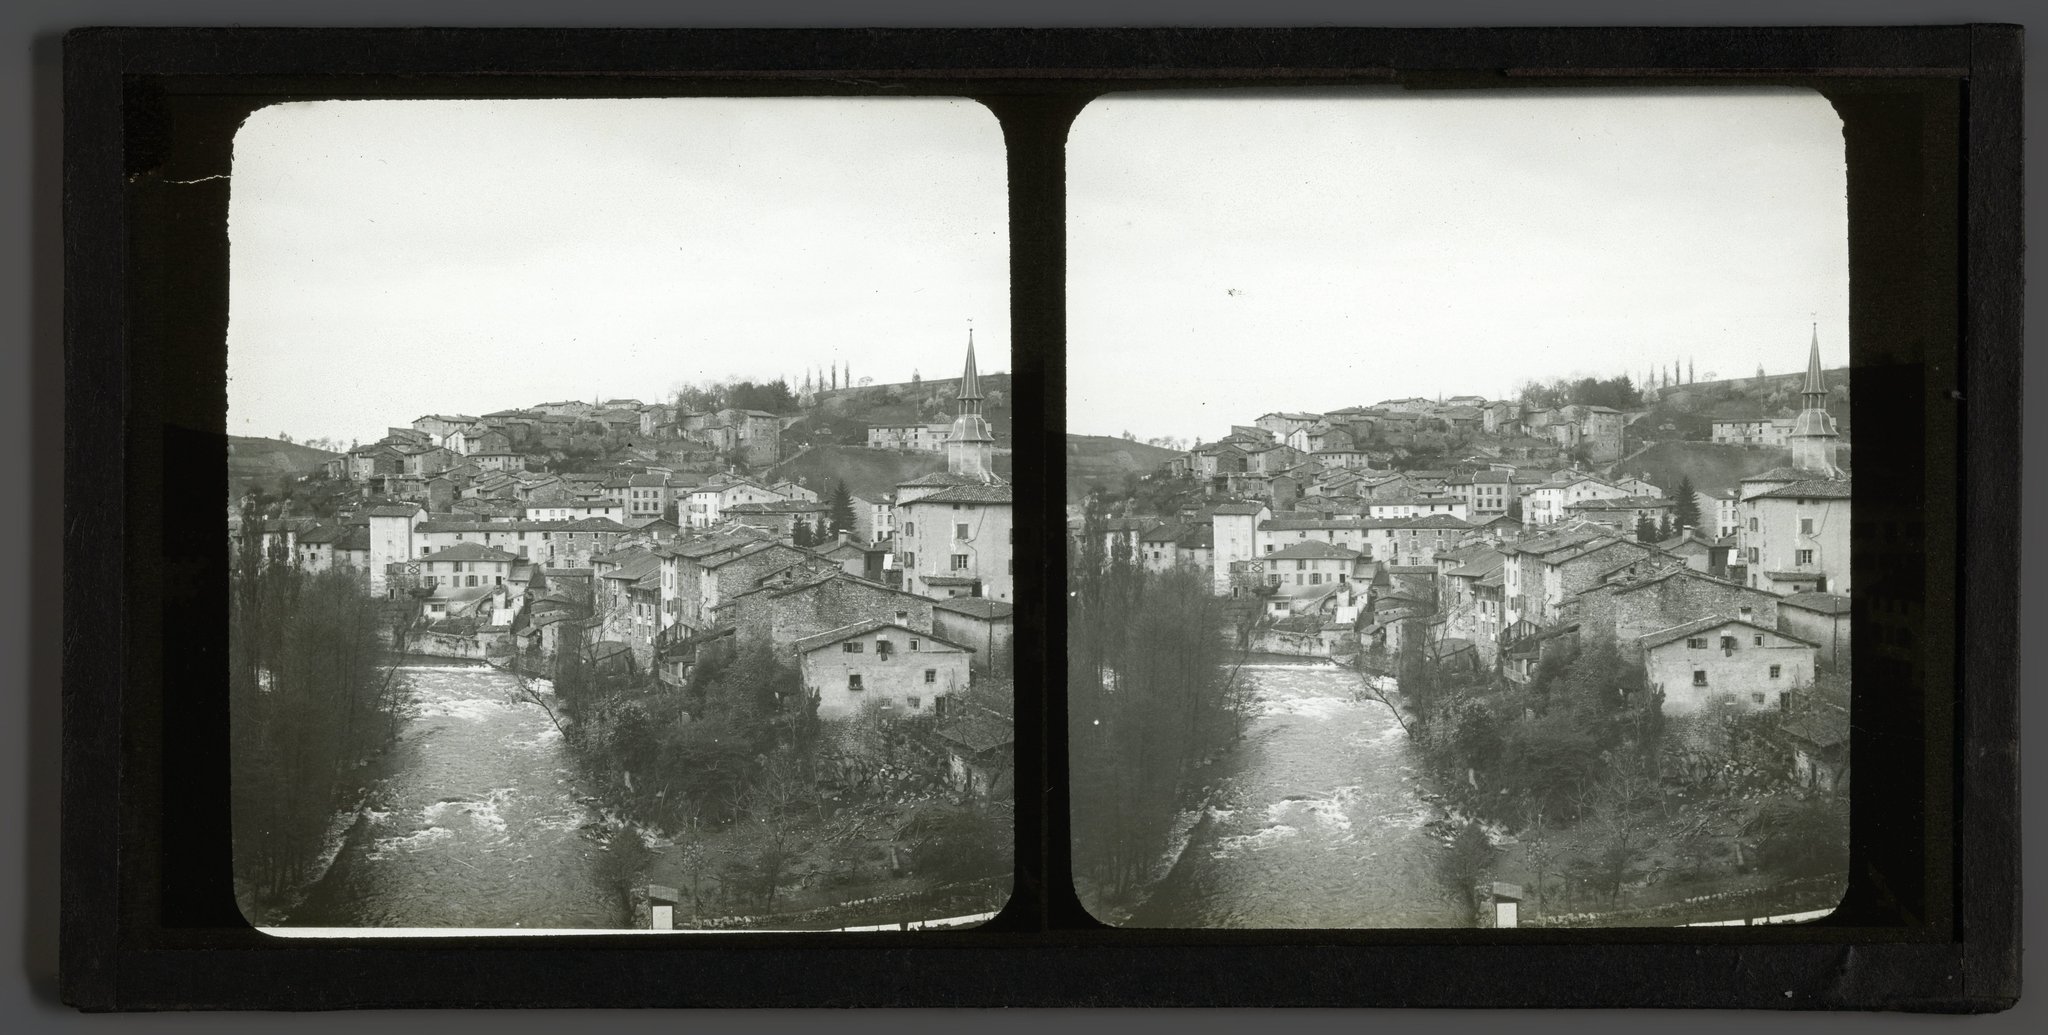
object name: stereoscopic photograph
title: Gezicht op een bergdorp aan een rivier, waarschijnlijk in Frankrijk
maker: Anonymous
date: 1860-1890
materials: glass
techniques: slide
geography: france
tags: river, village, france